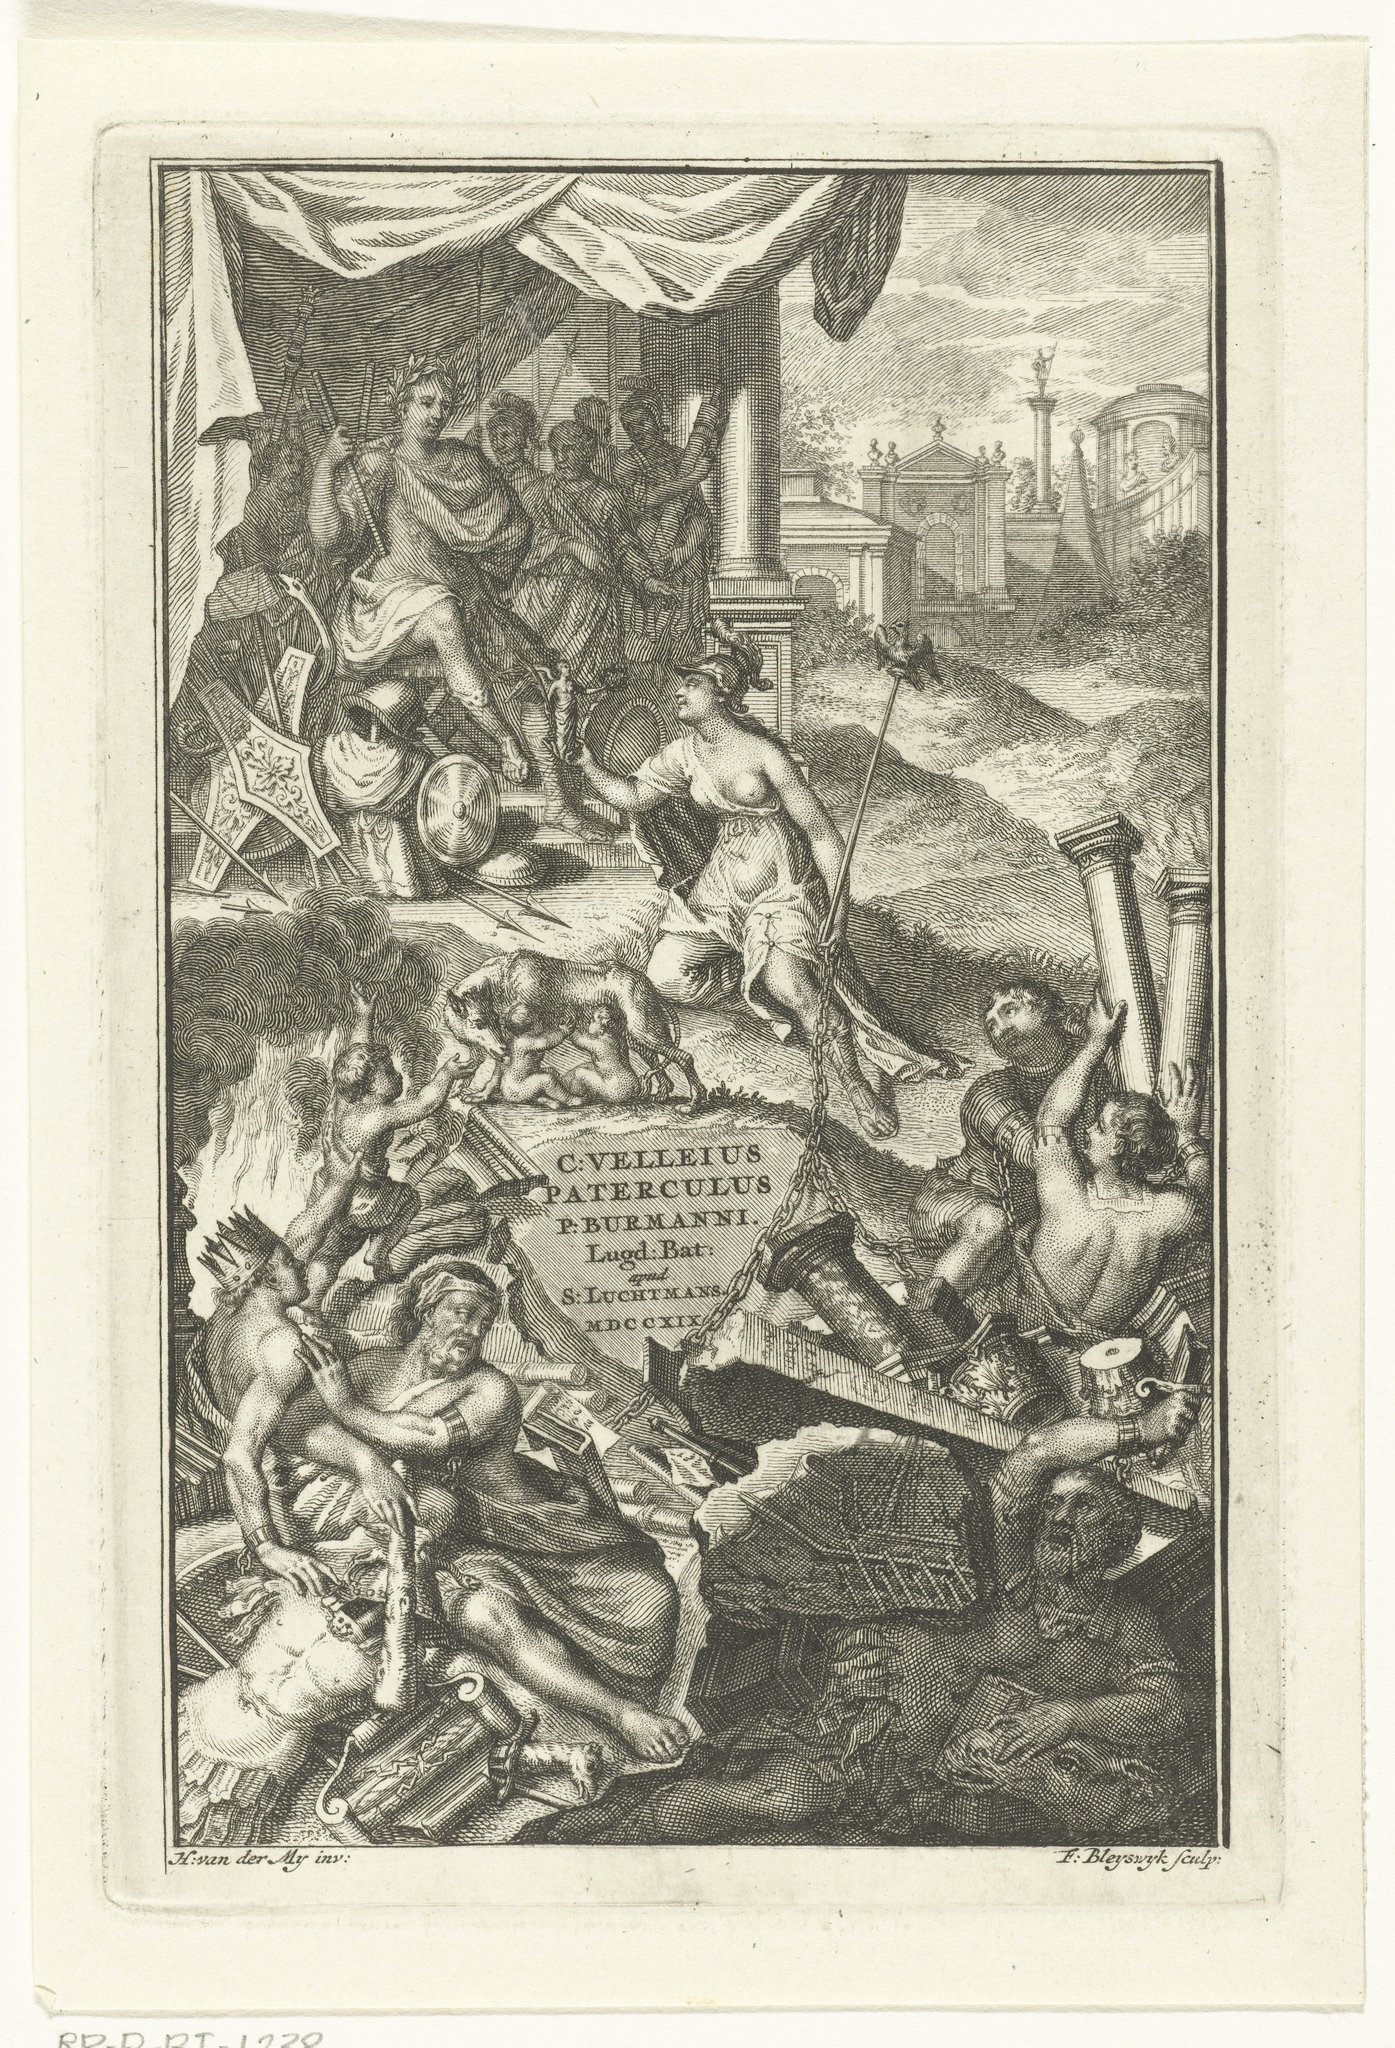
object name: print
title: Titelpagina voor: Pieter Burman, Gaius Velleius Paterculus, Leiden 1719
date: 1681-1719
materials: paper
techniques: engraving, etching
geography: leiden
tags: (story of) romulus and remus, heroes, male characters from the legendary origins of rome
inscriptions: collector's mark: Lugt 240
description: Marcus Velleius Paterculus krijgt als Romeinse veldheer wapentrofeeën en een beeldje van Victoria aangeboden. Tussen resten van verwoeste gebouwen liggen zijn gevangen genomen tegenstanders. Remus en Romulus voeden zich met melk van de wolvin.